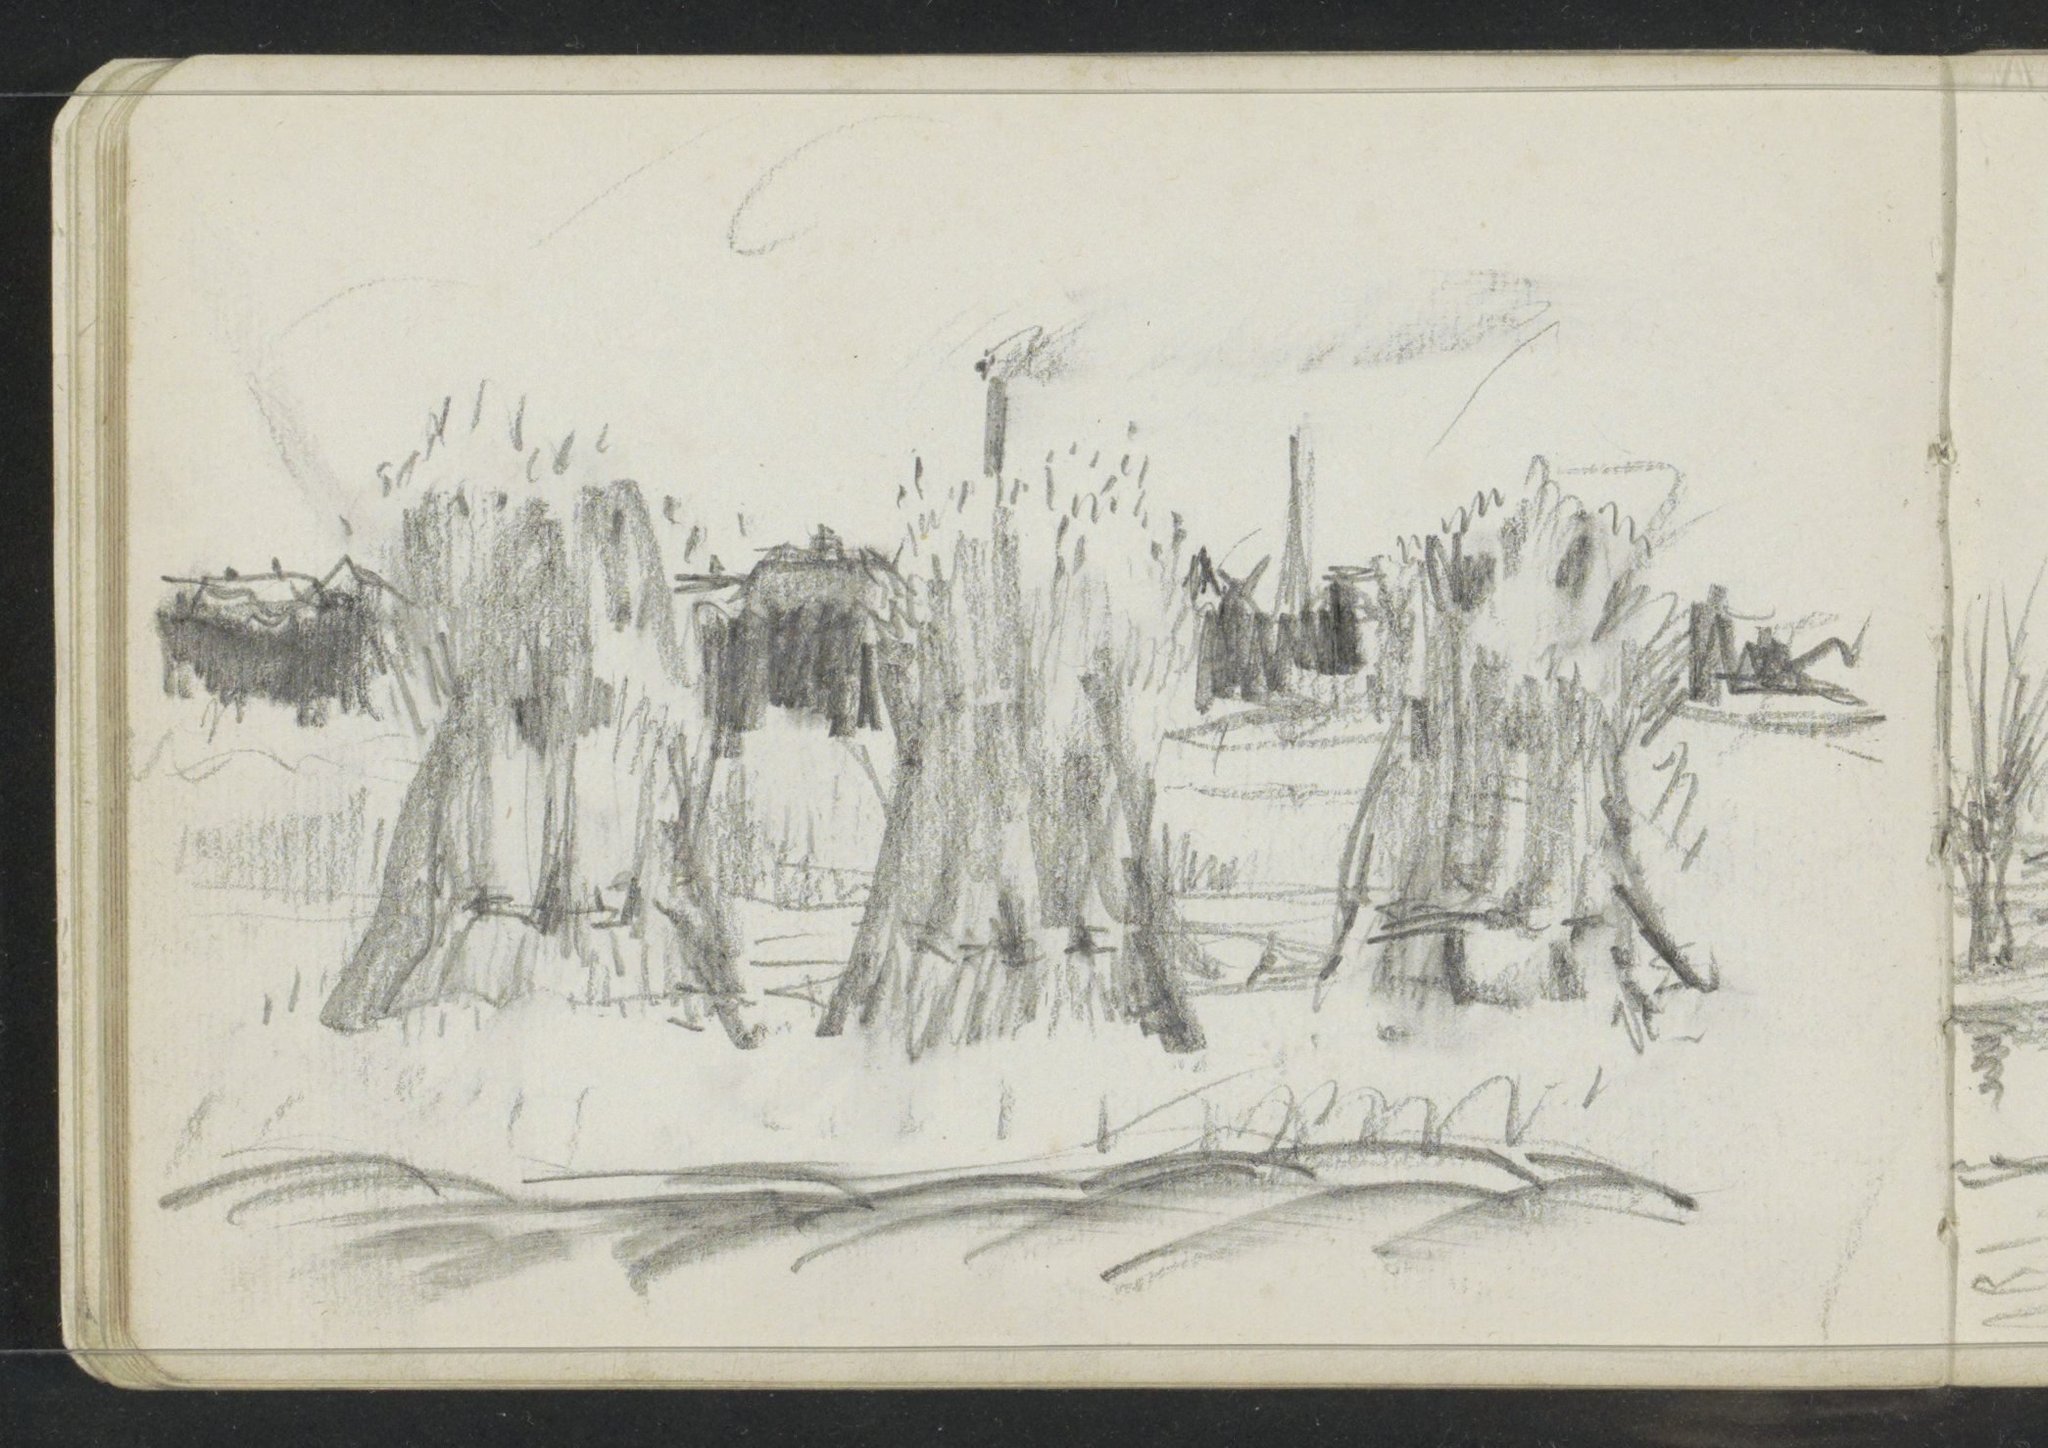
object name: sketchbook leaf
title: Korenschoven op een veld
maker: johanna van de kamer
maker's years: 1873-1922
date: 1883-1922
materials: paper, pencil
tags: sheaf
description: Blad 12 verso uit een schetsboek met 27 bladen.